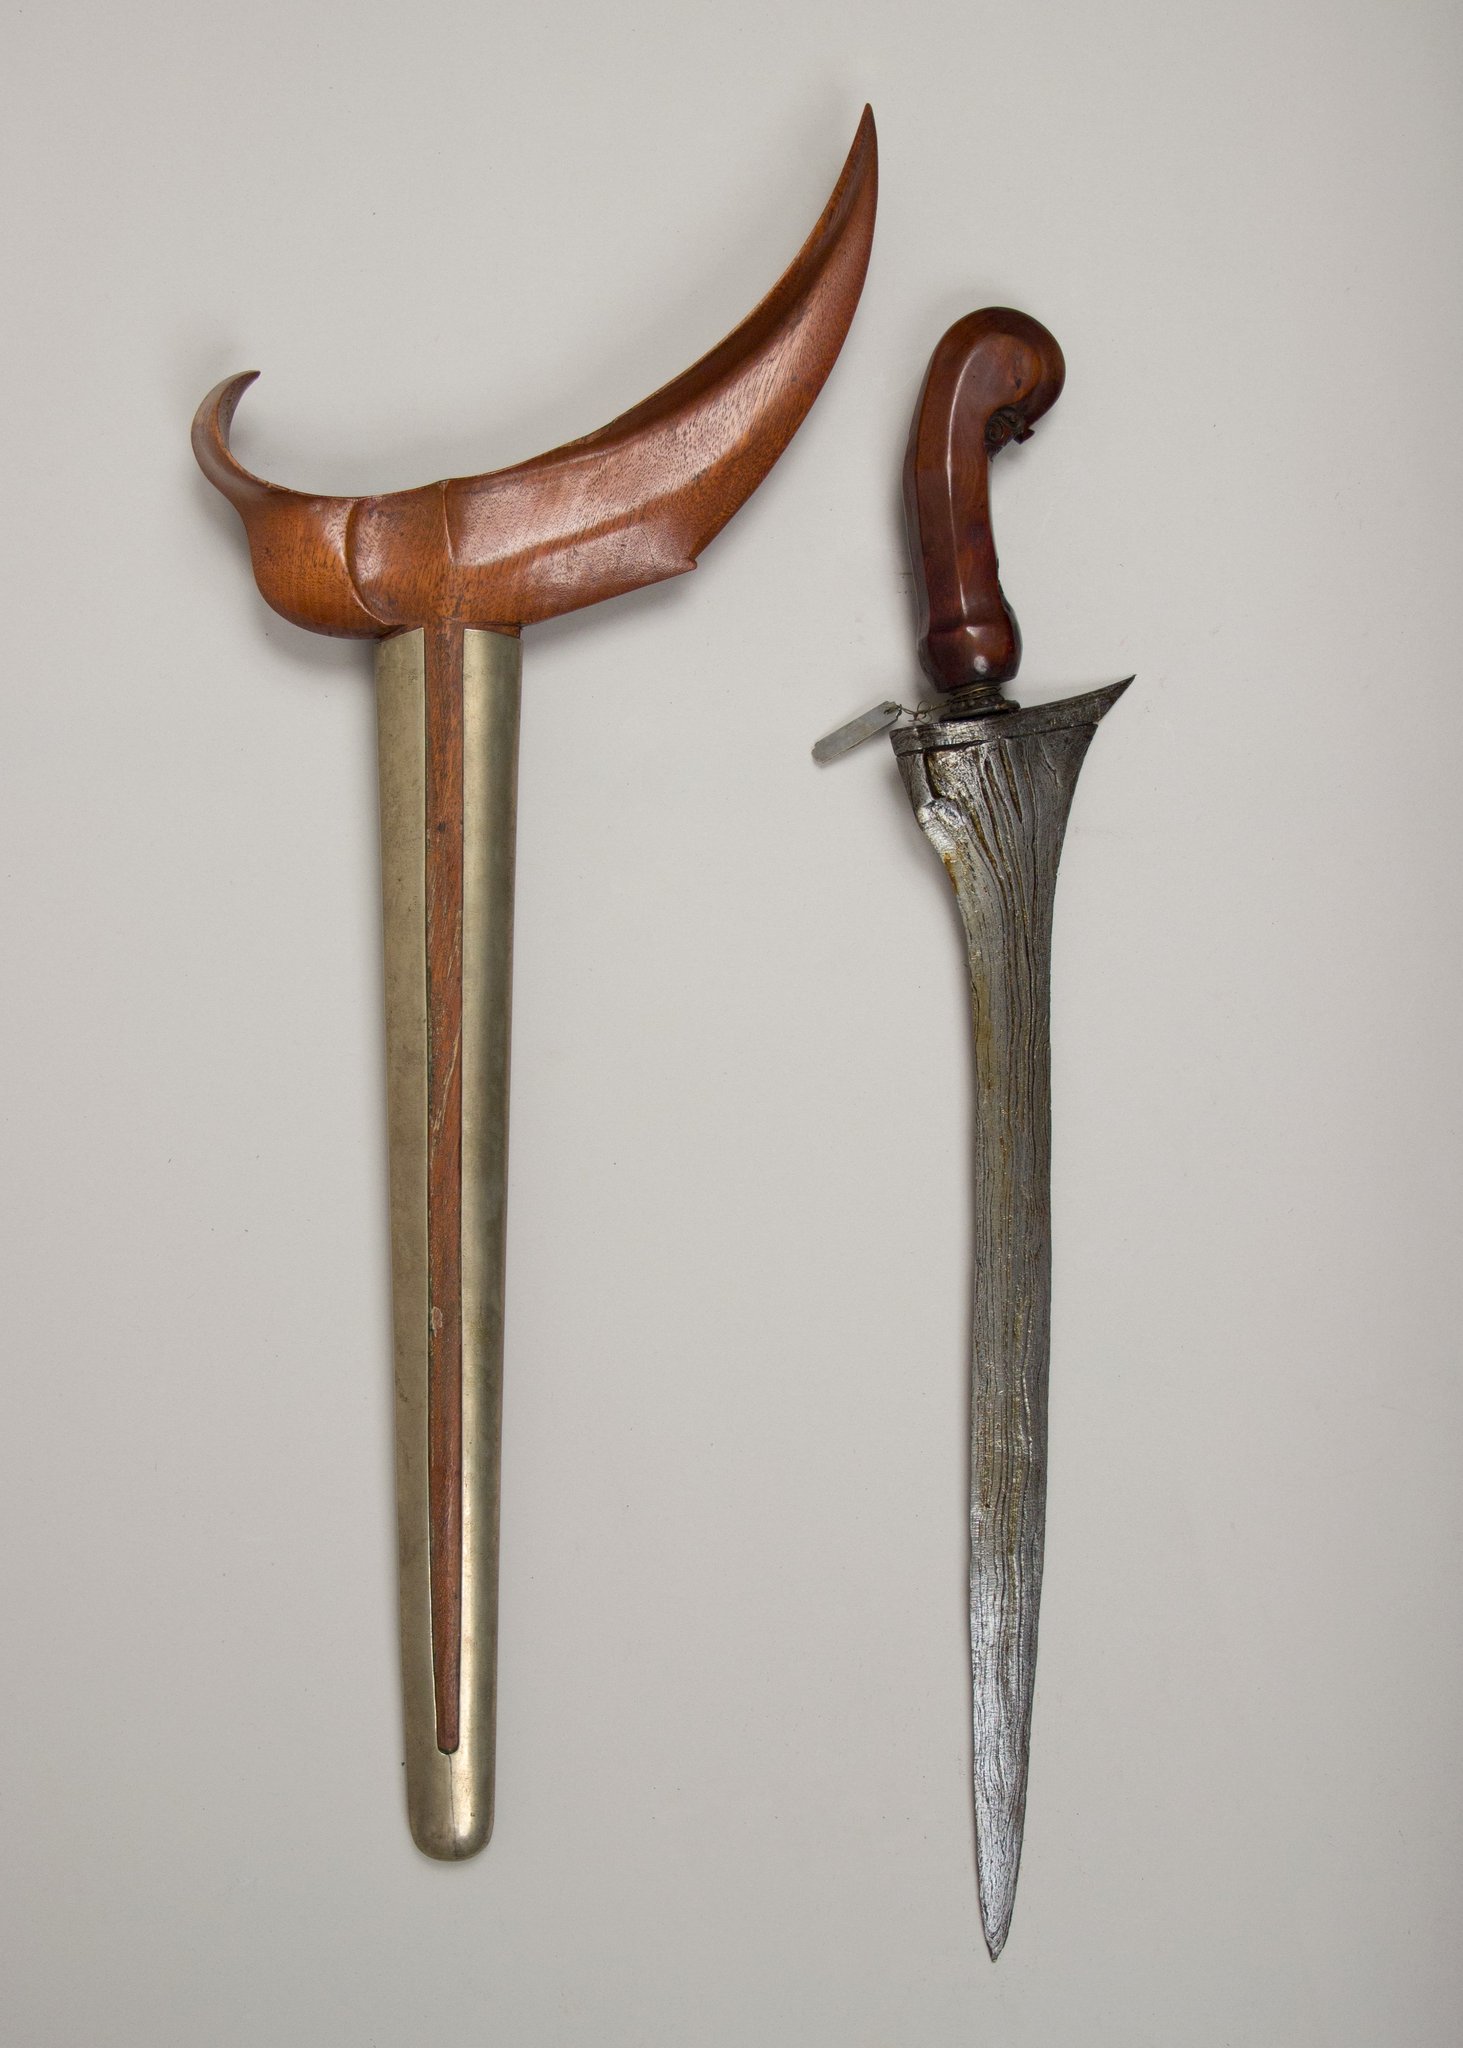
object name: kris with sheath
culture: javanese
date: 1501-1900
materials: brass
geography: indonesia